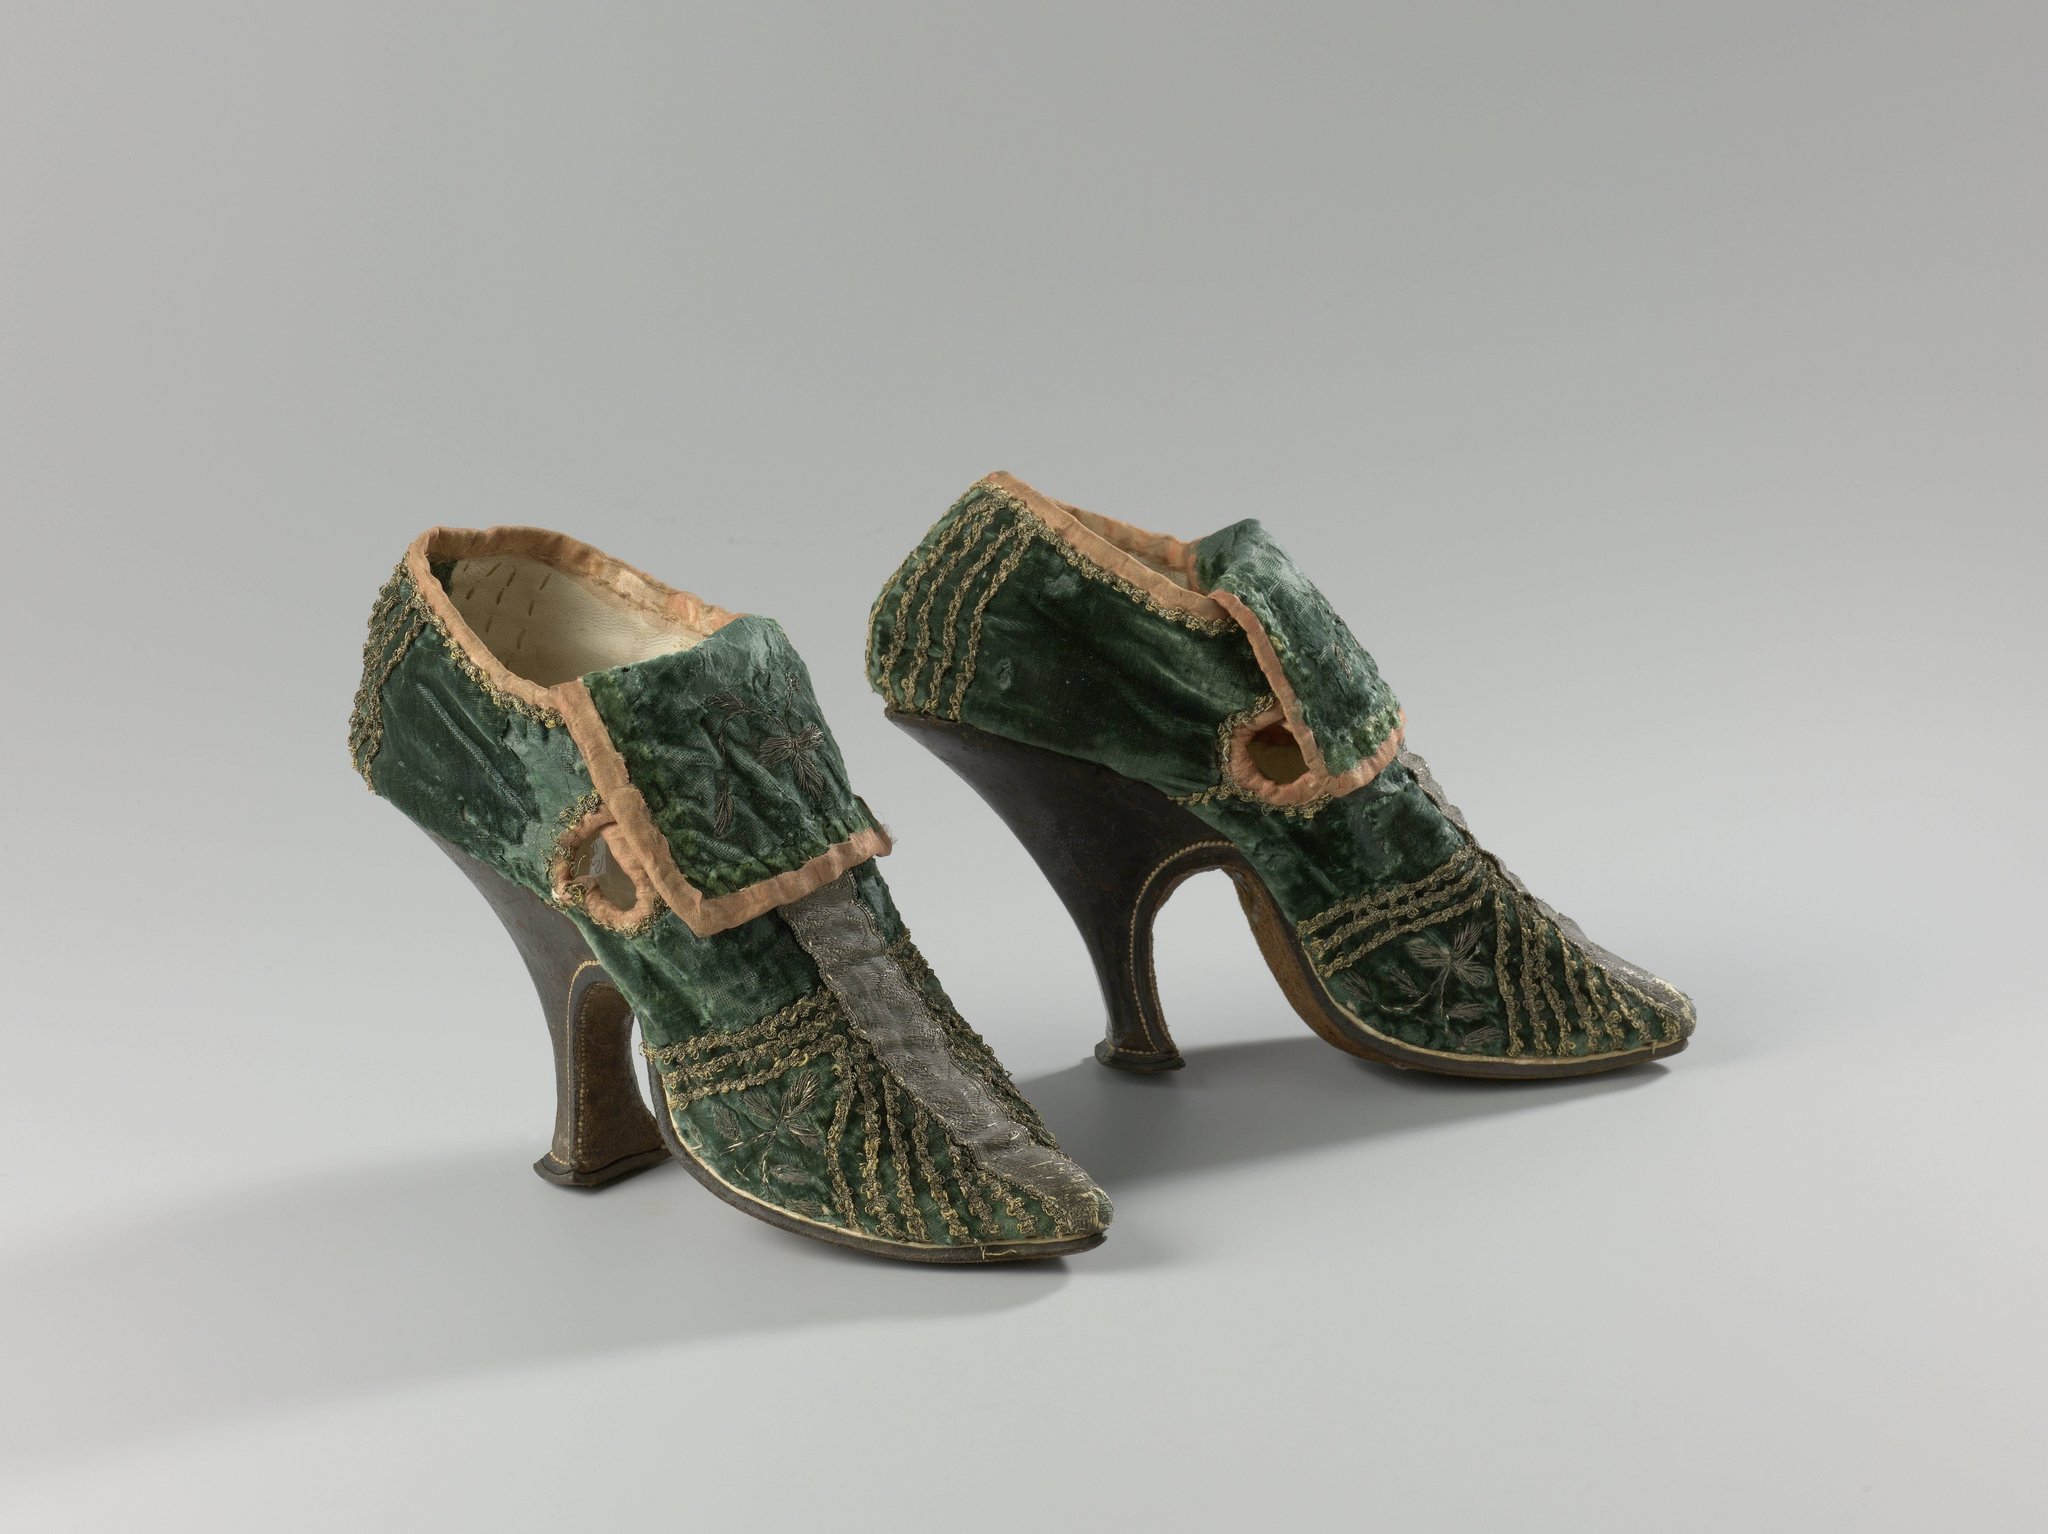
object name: womenswear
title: Pair of High-Heeled Women’s Shoes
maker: Anonymous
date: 1690-1710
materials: leather, silk, thread, velvet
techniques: tanning, weave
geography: northern netherlands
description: Damesschoen van groen fluweel versierd met passement van zilverdraad. Model: Korte voorvoet met spitse neus, één voorblad en twee zijbladen. Openingen ter weerszijden van de voet. Van de wreef afhangende flap. De hoge hak staat halverwege het geleng. De voorkant van de hak is in een u-vorm verbonden met de voorvoet en loopt recht naar beneden. De zijkant en achterkant van de hak is getailleerd en bekleed met donkerbruin leer. Langs de rand van de hak crèmekleurige stiksels. Tussen de bovenkant van de schoen en de zool een smal randje wit leer; typisch voor de 17de eeuw. Leren achterlapje en geruwd leren zool. Zijbladen en voorblad gevoerd met ivoorwit leer. De binnenzool is van ivoorwit leer. De naden zijn gevoerd met een band groen fluweel. Versiering: Over de de voorvoet en de hiel zijn diagonale passementen van zilverdraad gelegd. Vanaf de neus tot op de wreef een breed zilveren passement. Op de flap en op de zijkanten van de voorvoet florale borduursels van zilverdraad. Schachtrand afgebiesd met oranjeroze zijde.